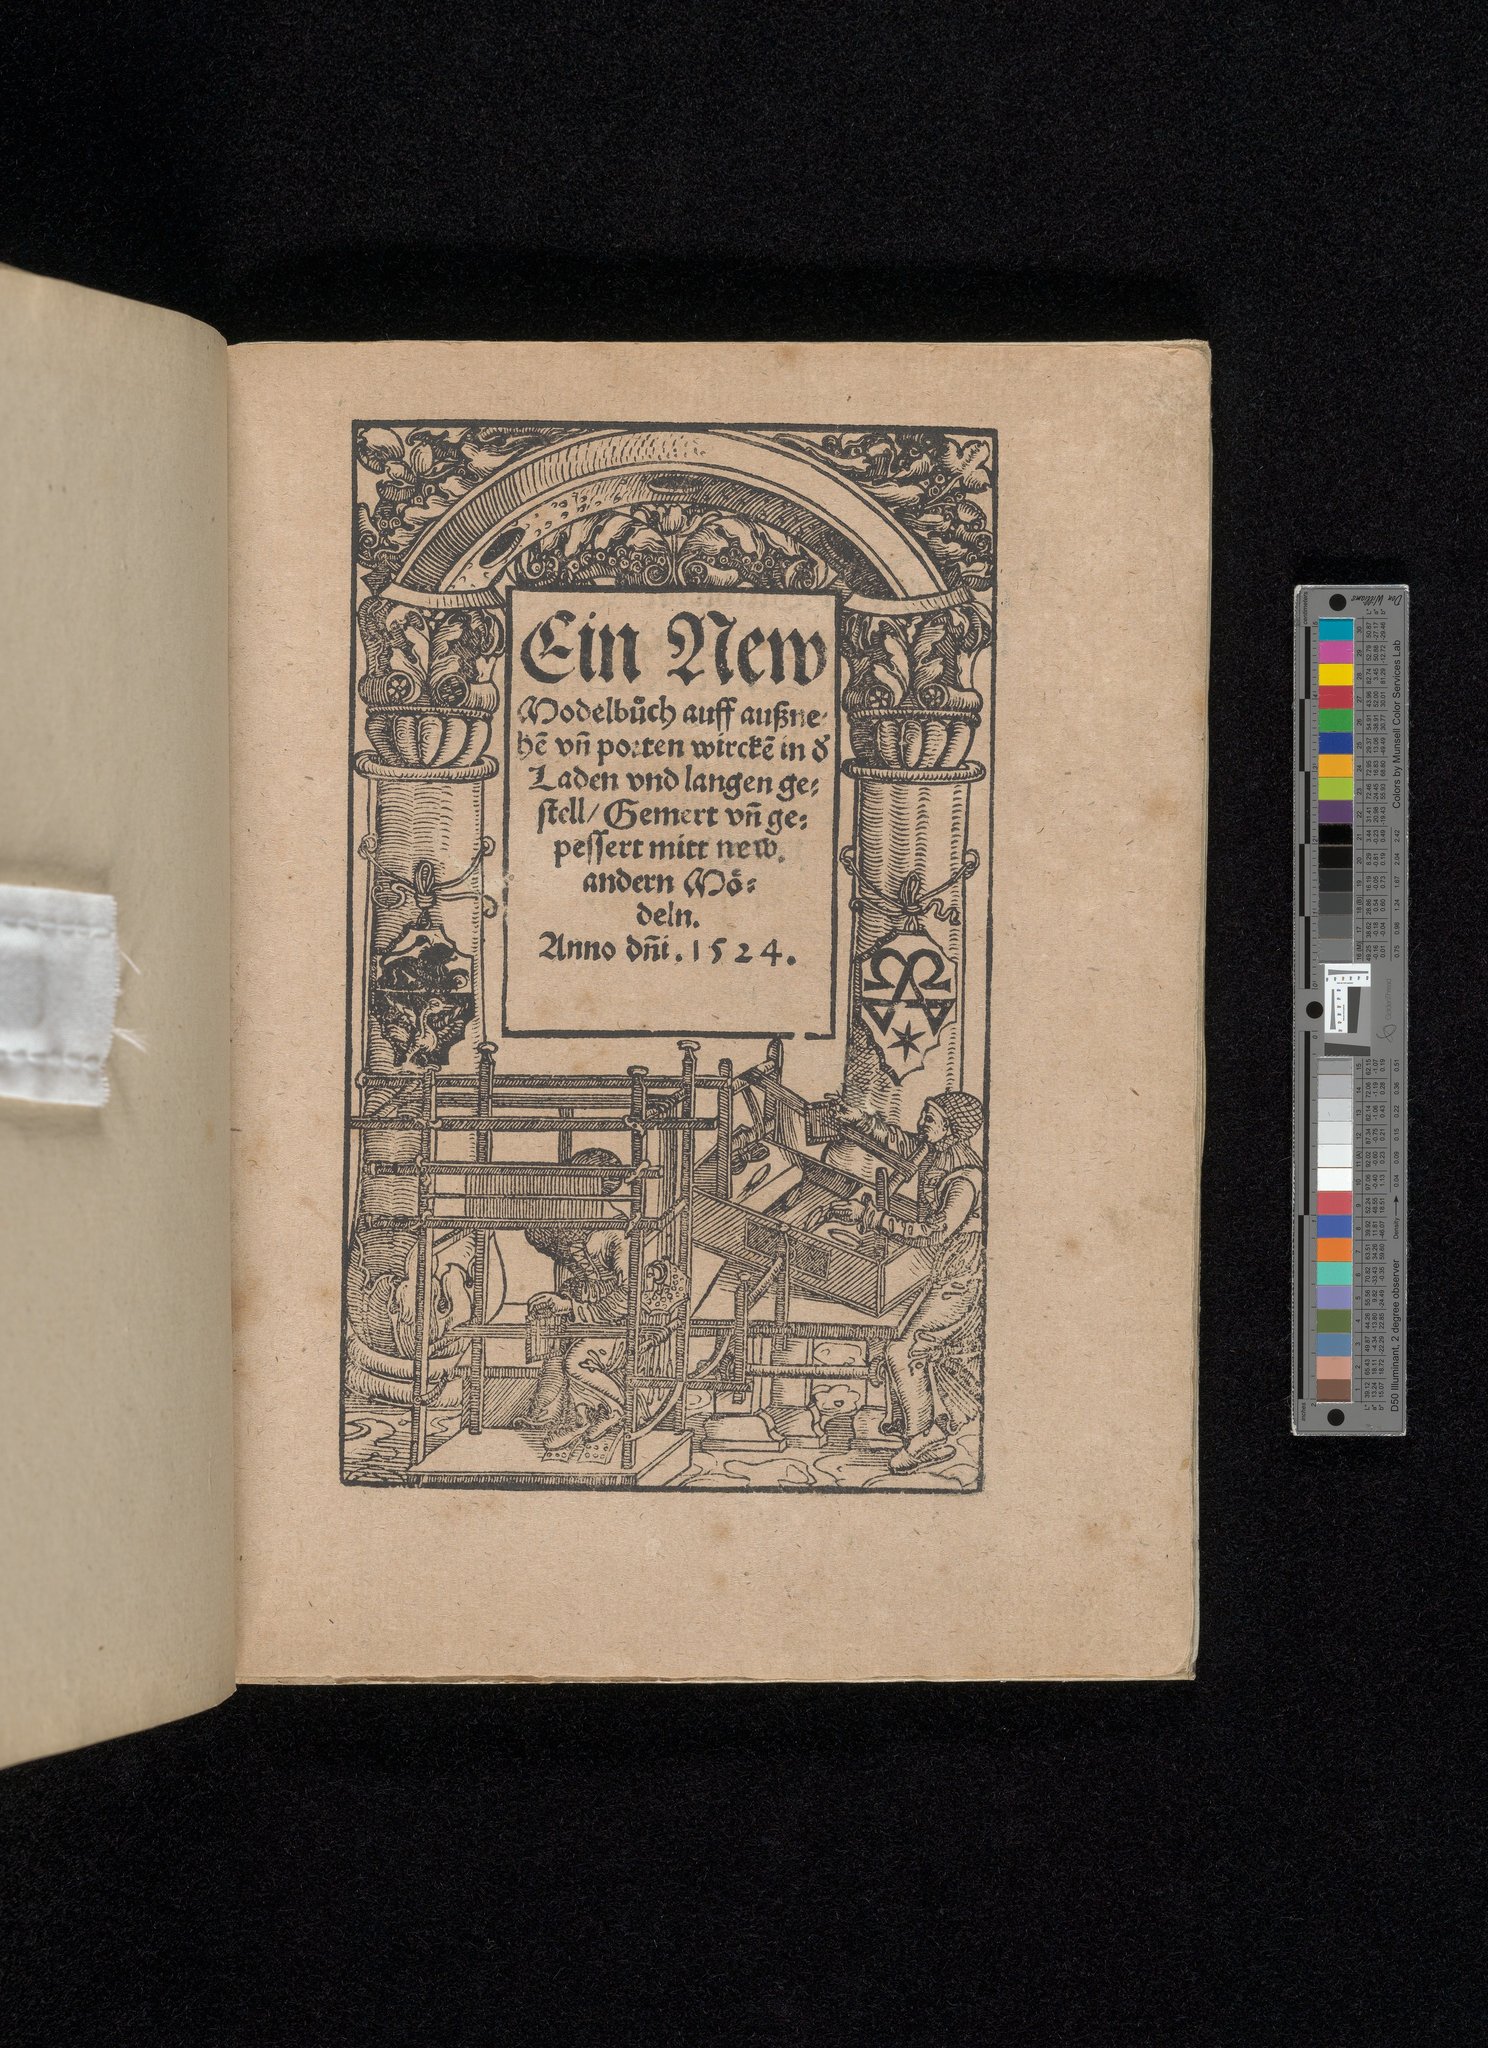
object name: book print ornament architecture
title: Ein new Modelbuch..., title page (recto)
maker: johann schönsperger the younger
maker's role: publisher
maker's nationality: german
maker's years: 1490-1550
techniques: woodcut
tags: women,working